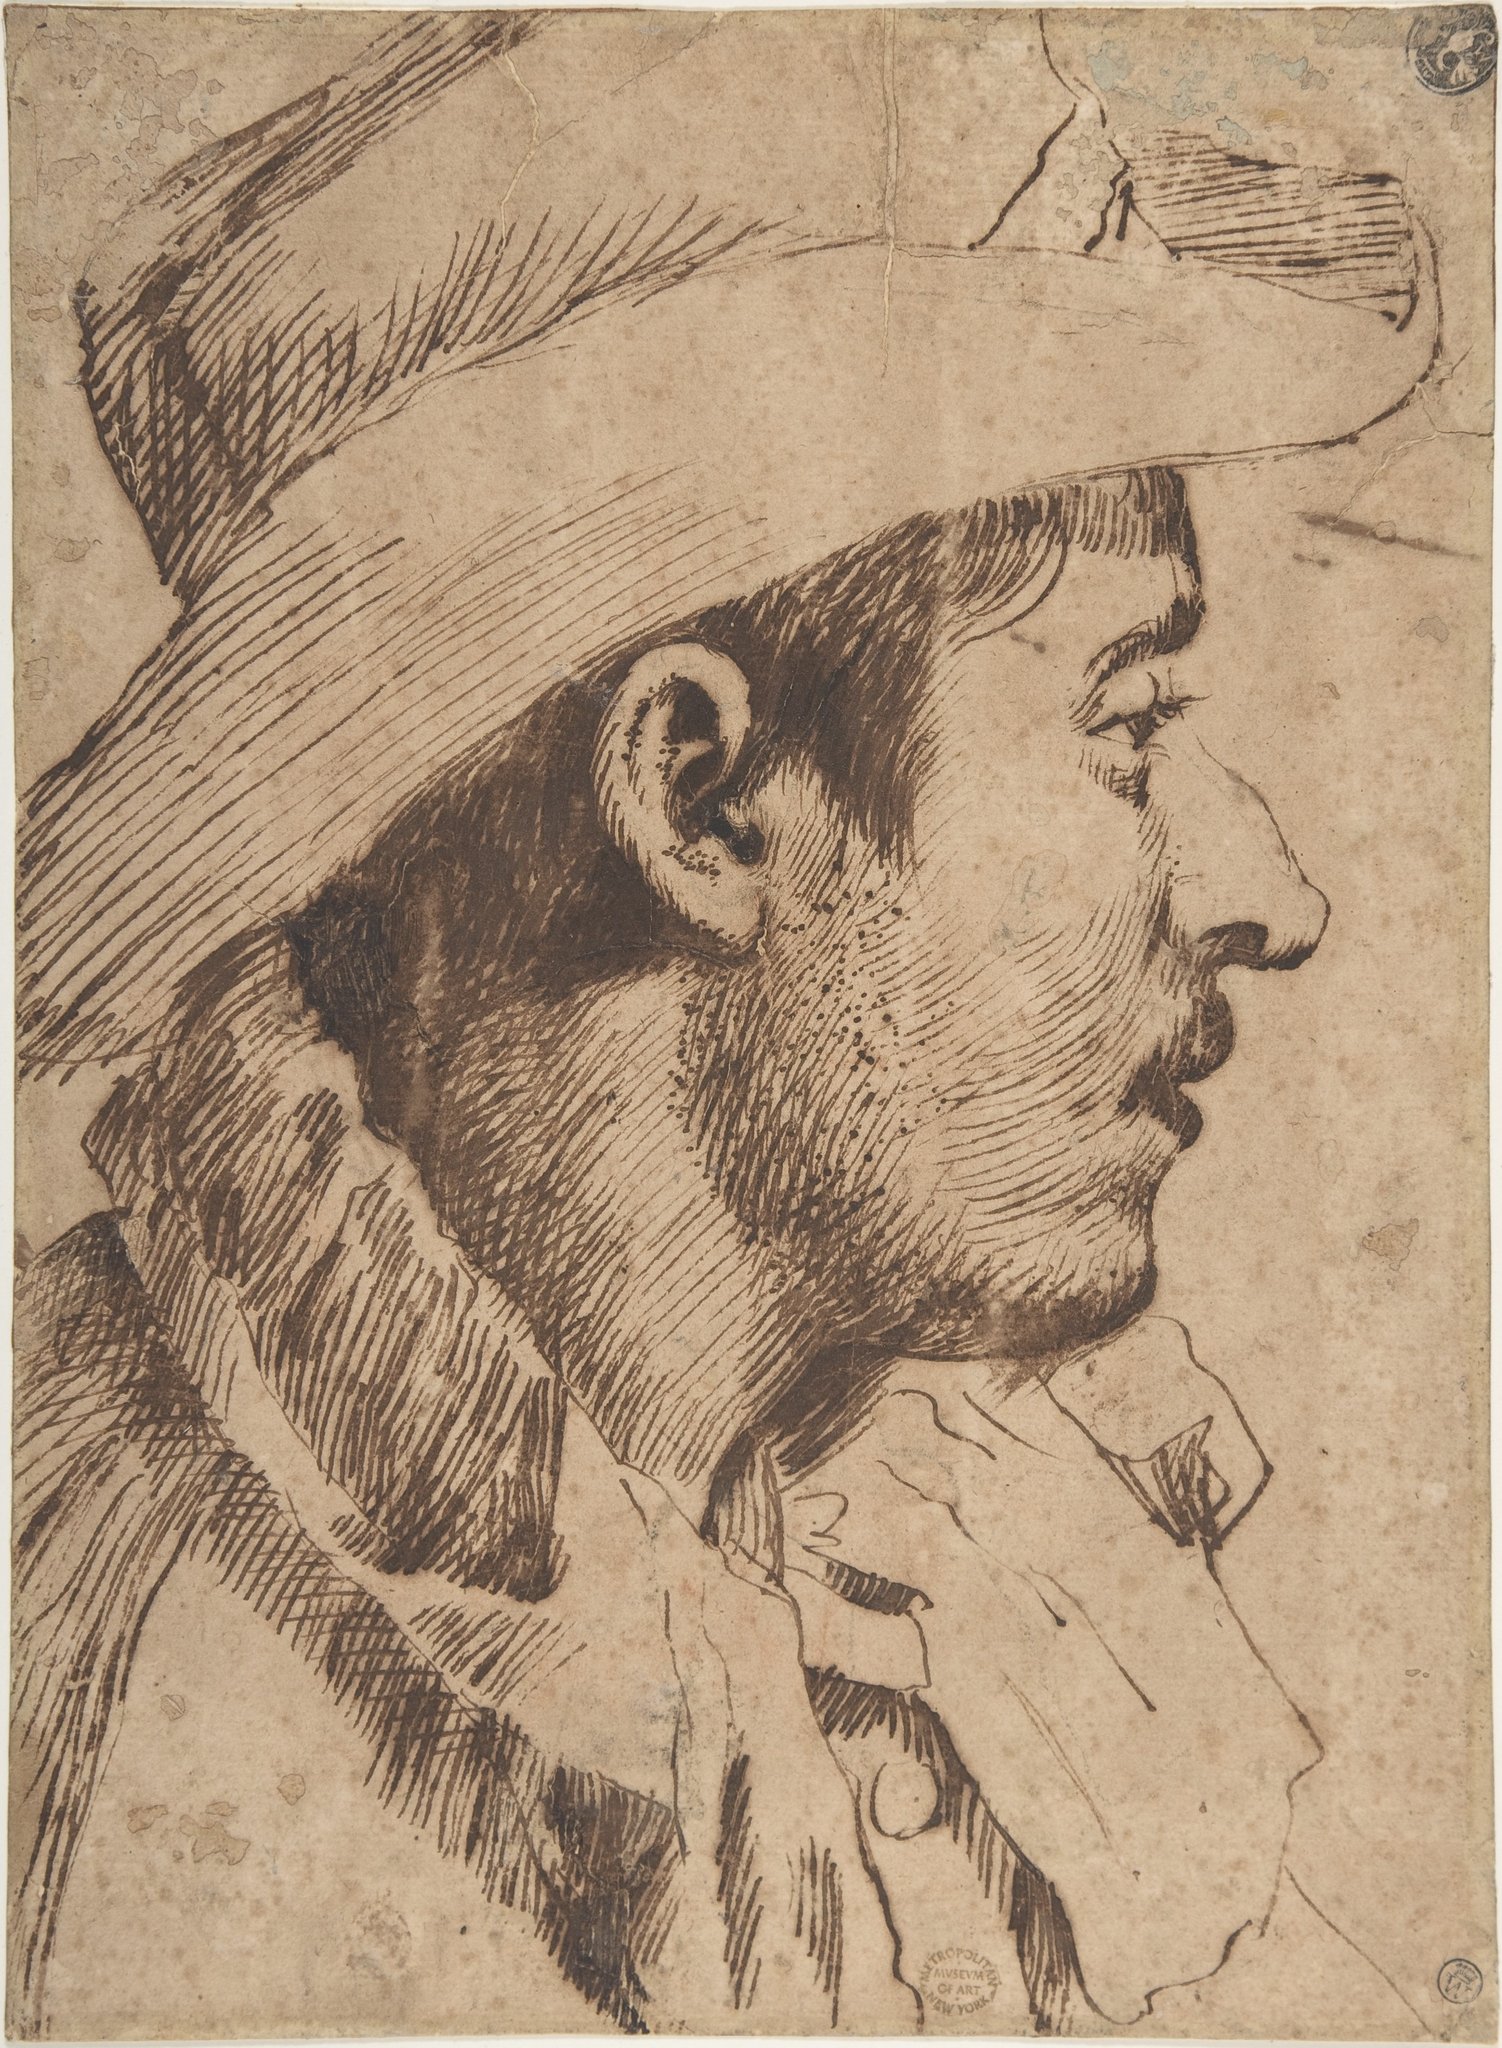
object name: drawing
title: Head of a Young Man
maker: anonymous, italian, bolognese, 17th century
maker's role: artist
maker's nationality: italian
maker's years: 1600-1700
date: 1560-1609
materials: ink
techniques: pen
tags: heads,men,profiles